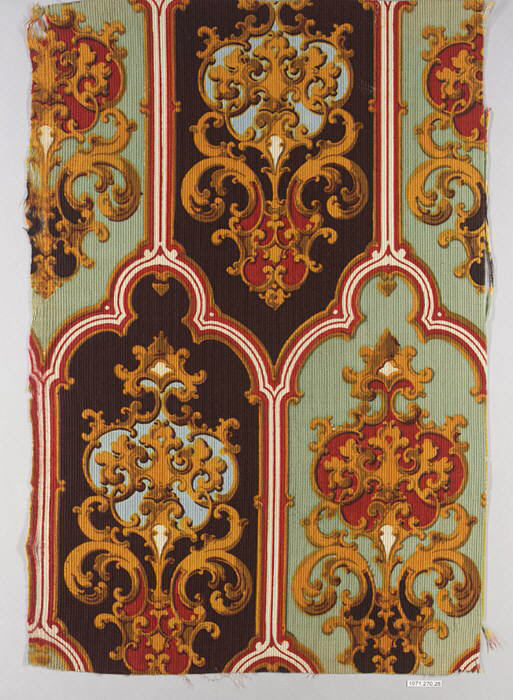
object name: piece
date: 1850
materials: wool